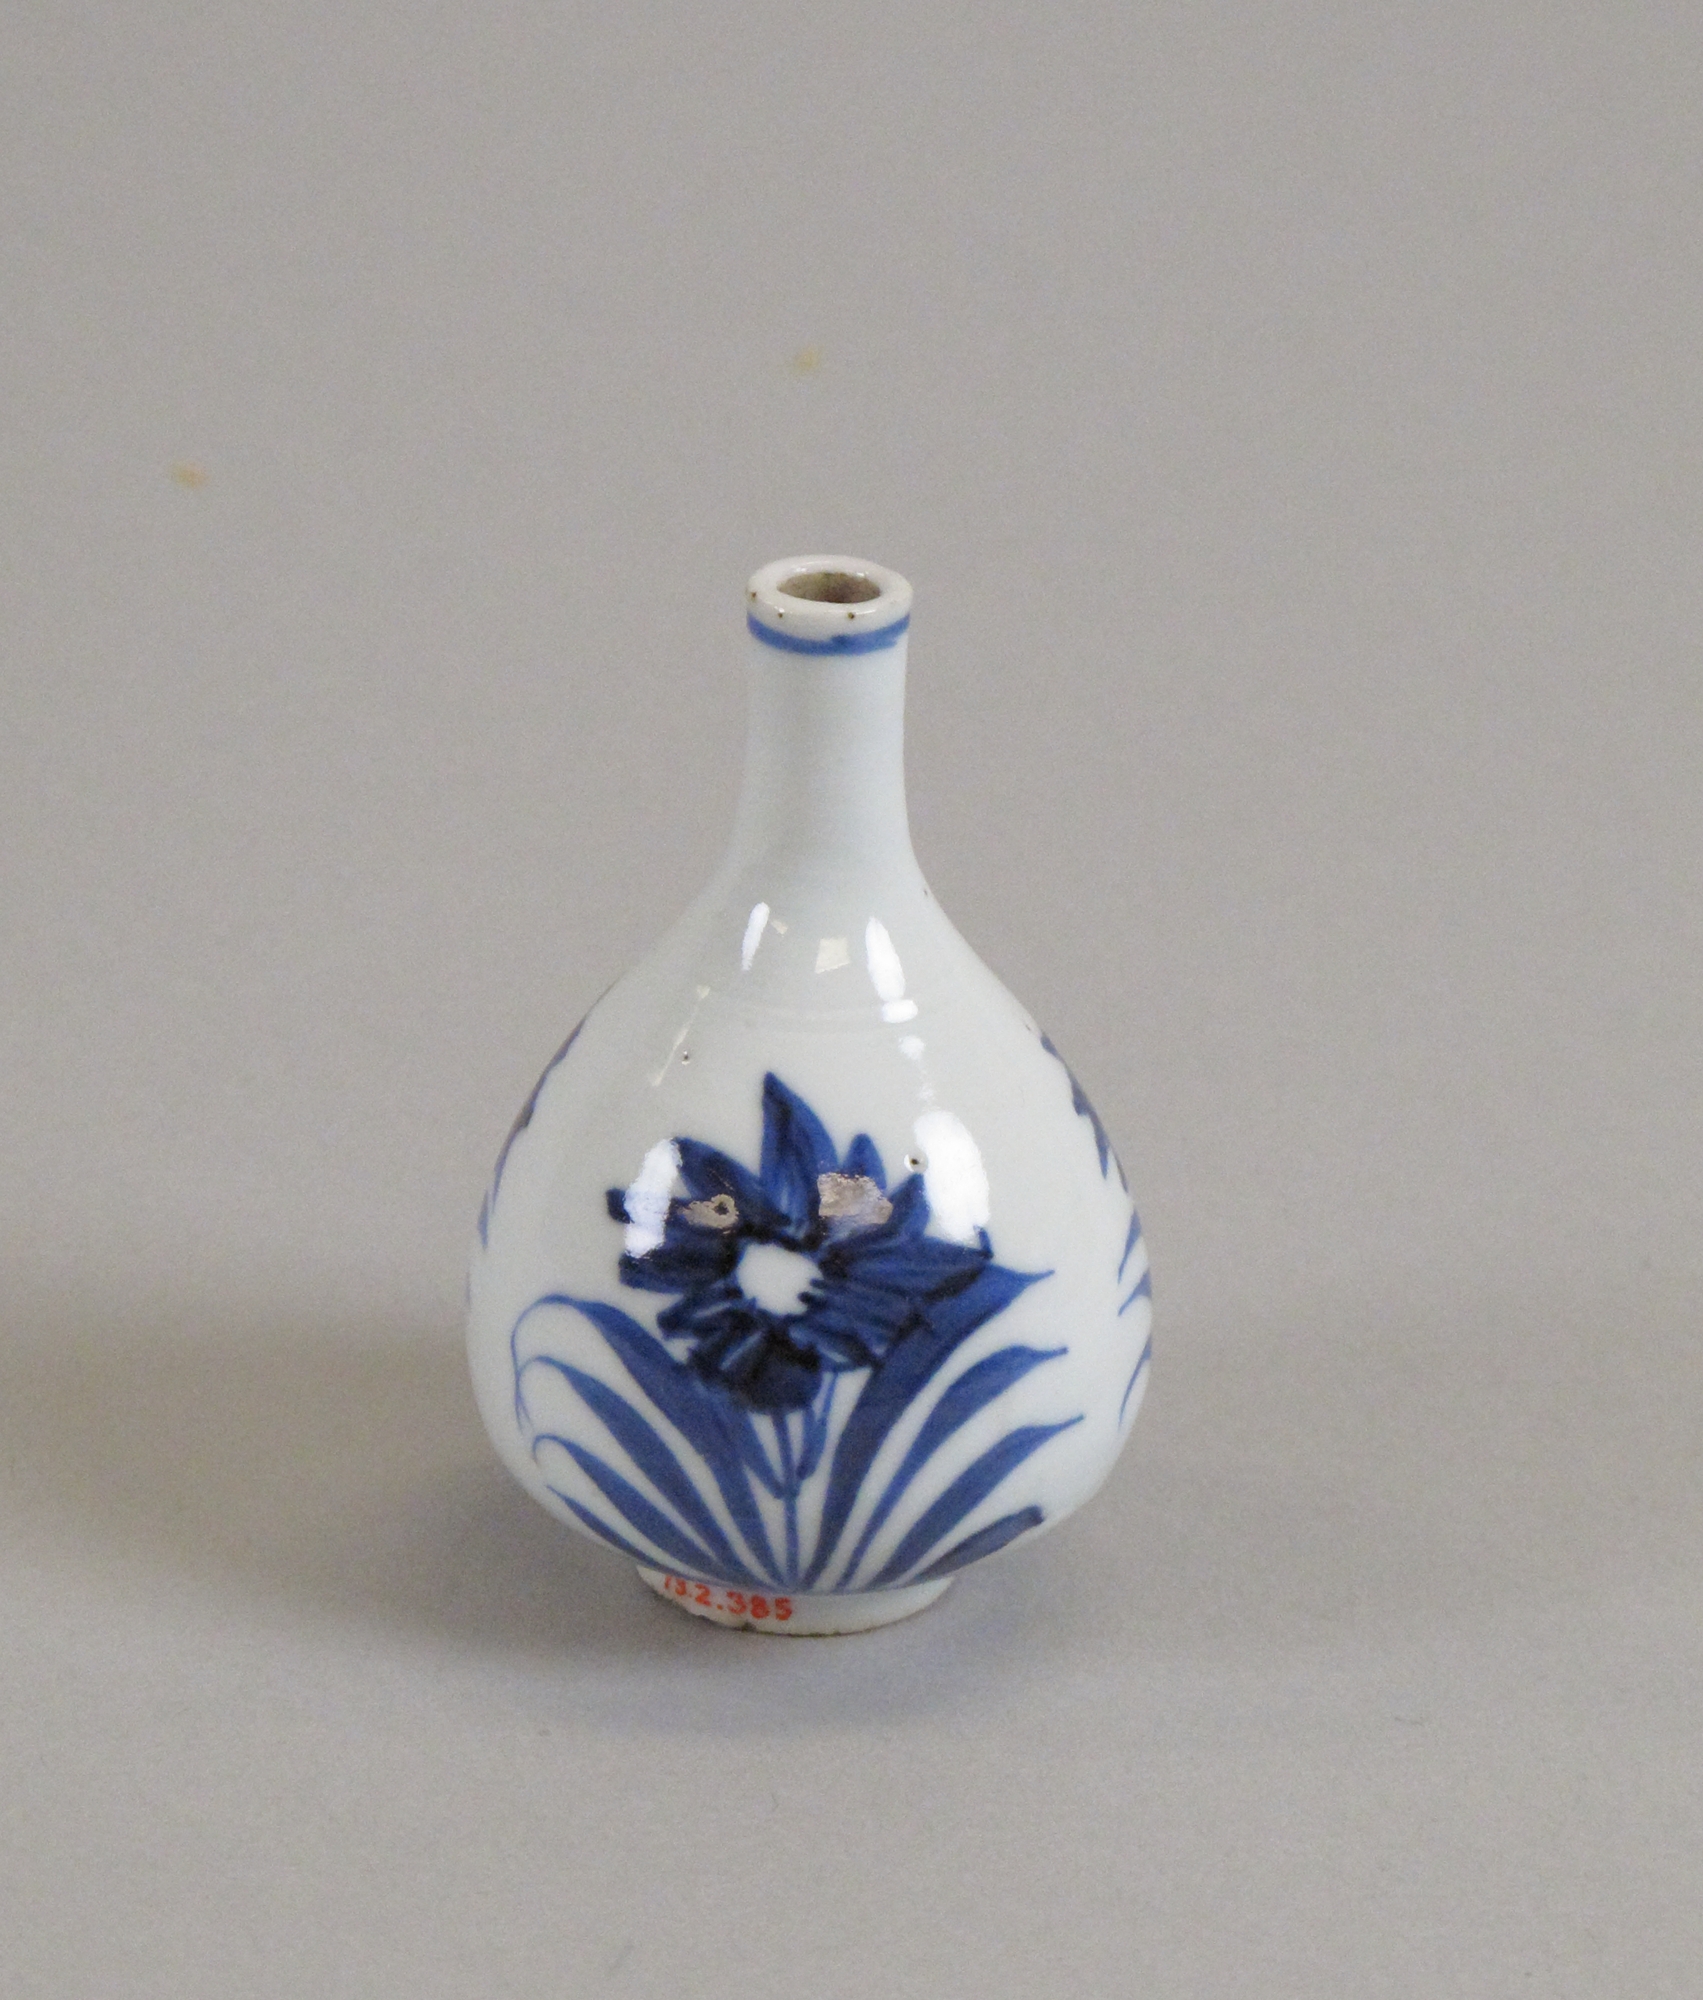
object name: bottle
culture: chinese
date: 1801-1850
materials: porcelain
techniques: painting, underglaze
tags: flowers